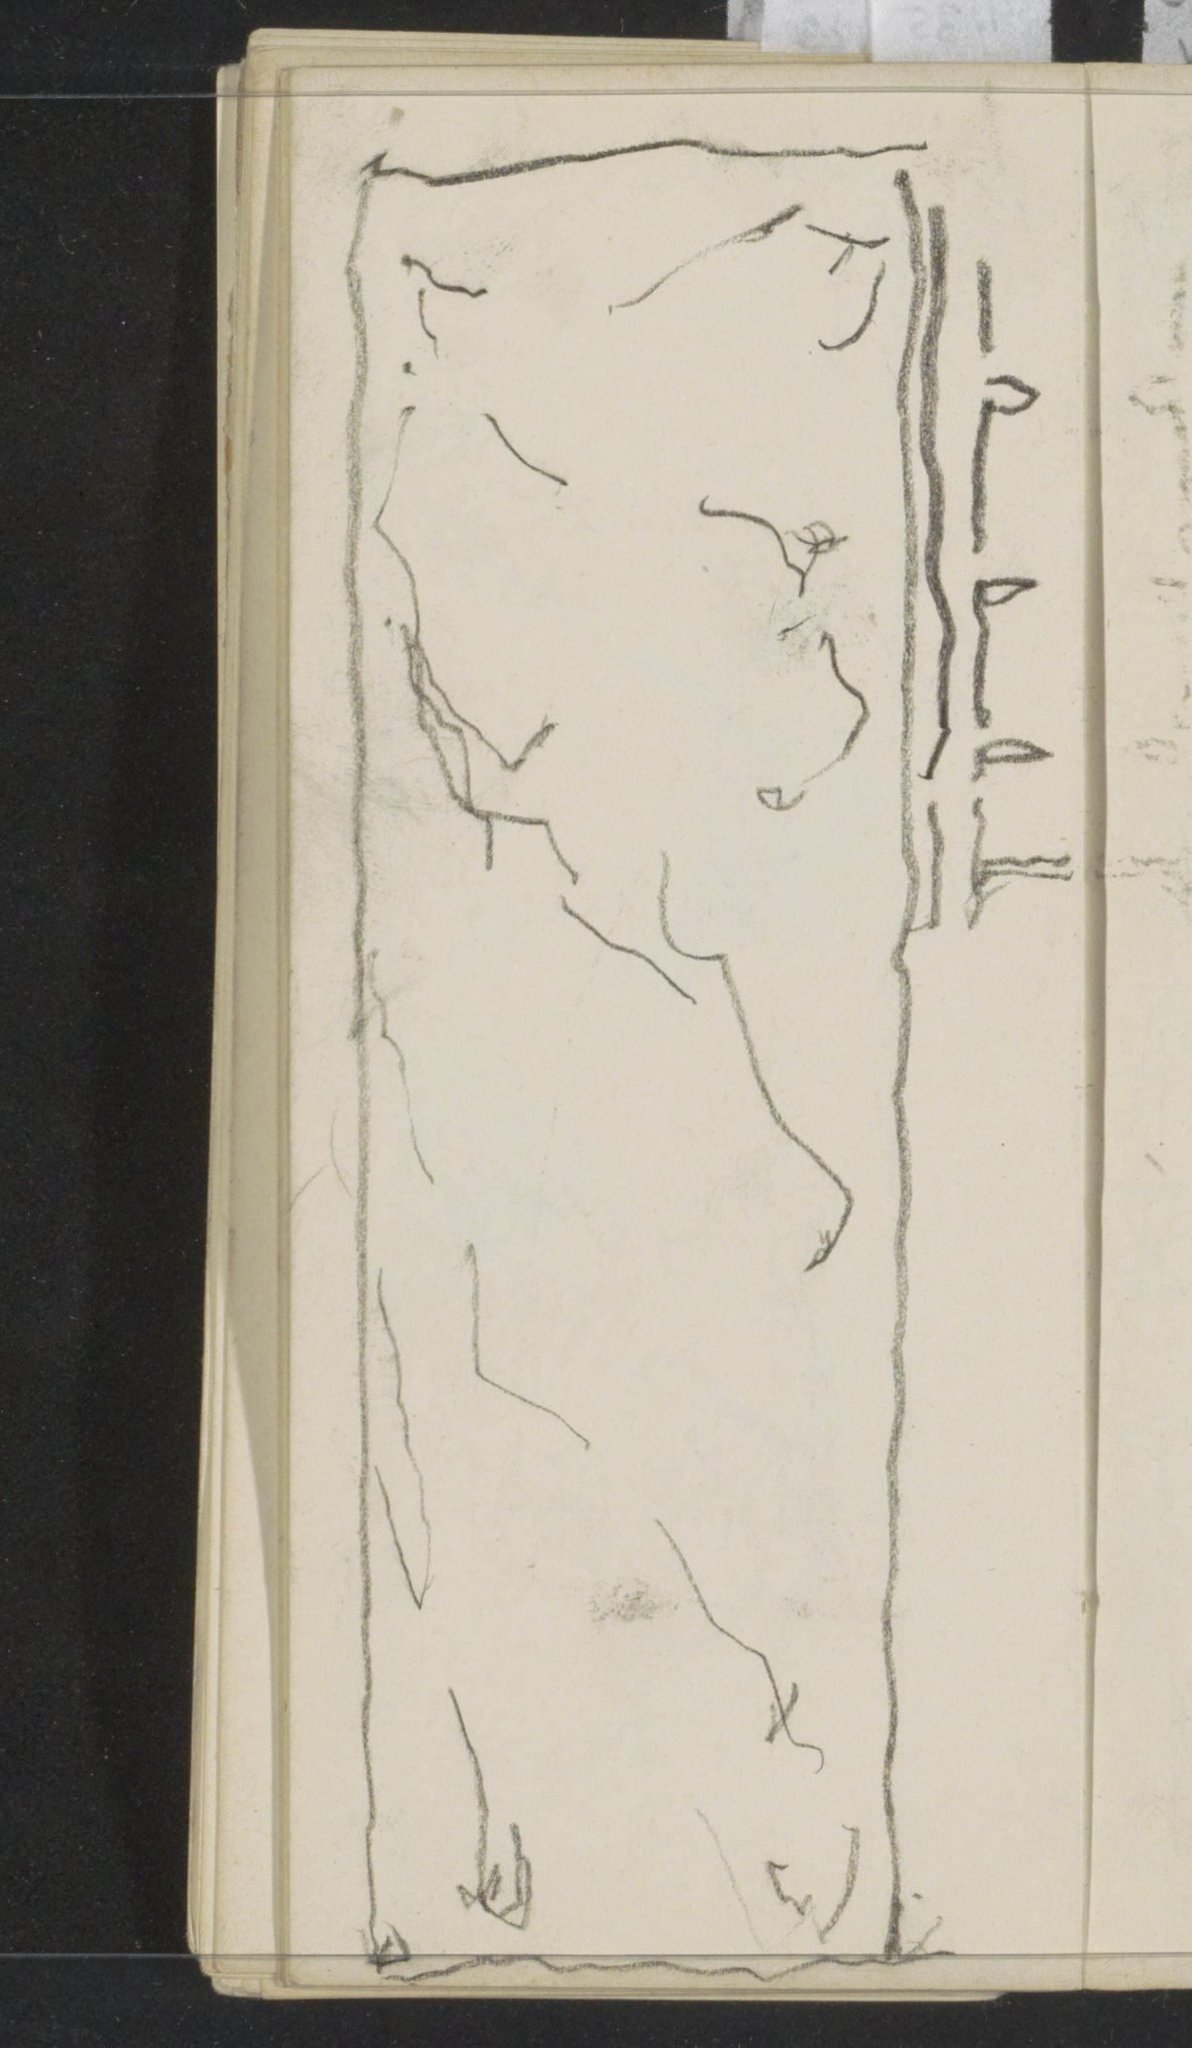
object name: sketchbook leaf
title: Studie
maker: gerrit willem dijsselhof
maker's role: designer, draughtsman, print maker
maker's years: 1866-1924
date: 1901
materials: chalk, paper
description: Blad 38 verso uit een schetsboek met 42 bladzijden.